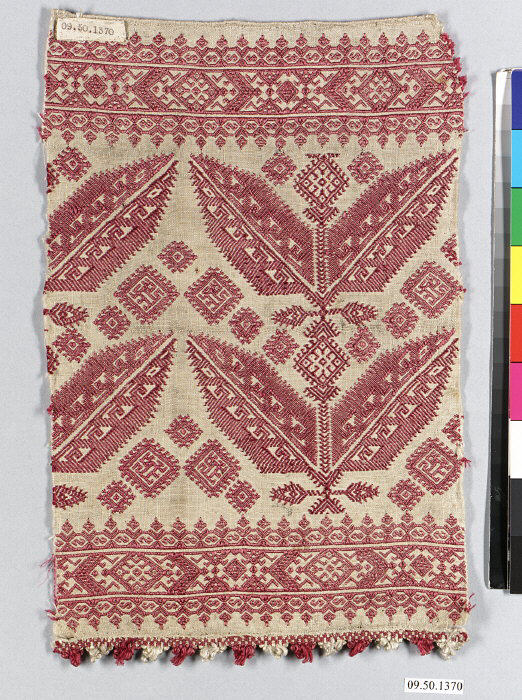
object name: fragment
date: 1701-1800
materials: cotton